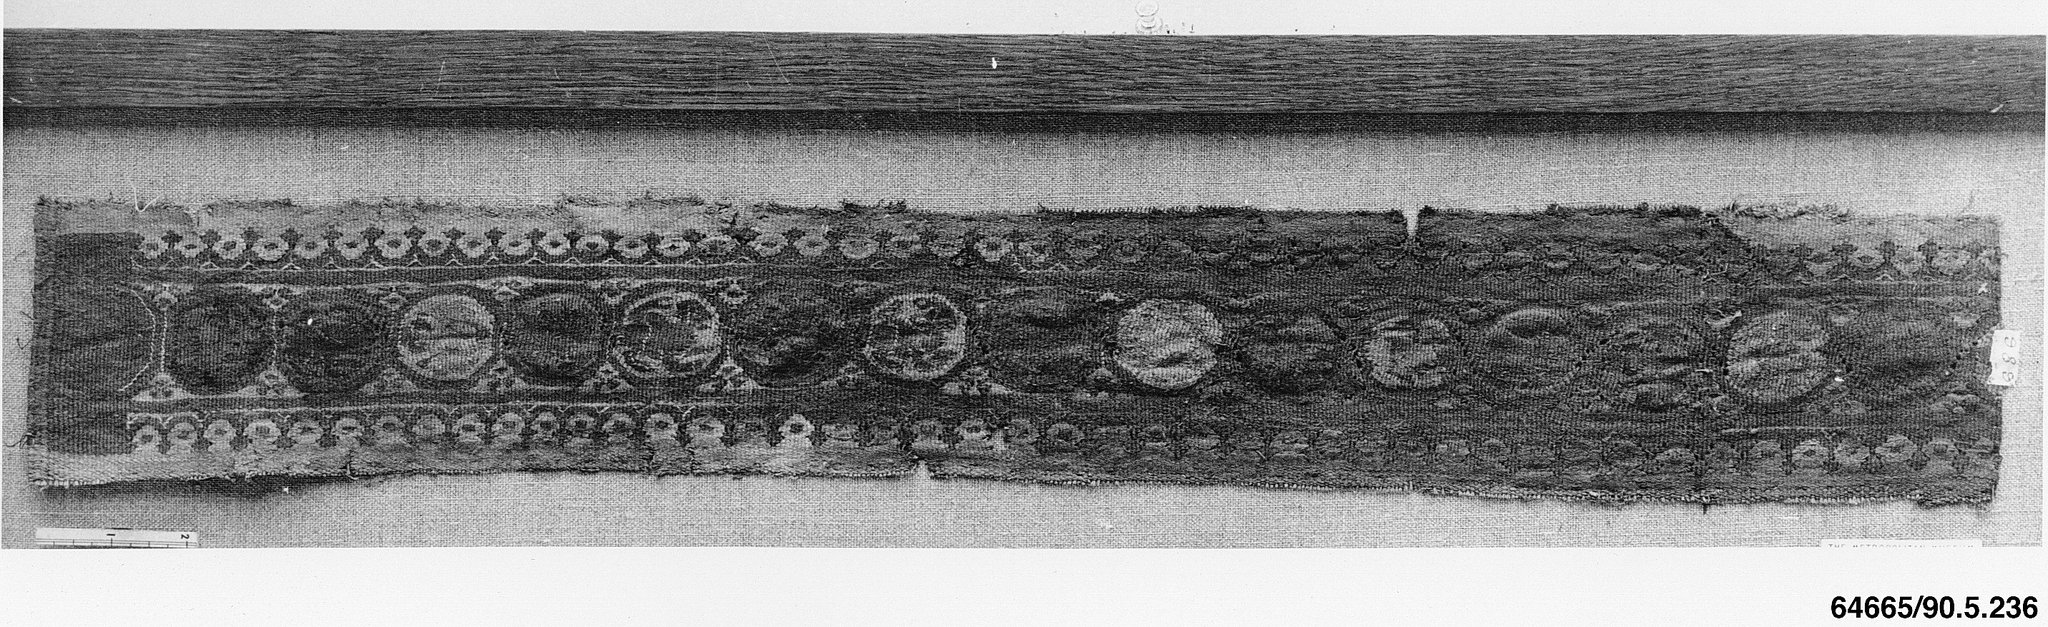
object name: textile fragment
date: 301-500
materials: linen, wool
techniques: weave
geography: egypt